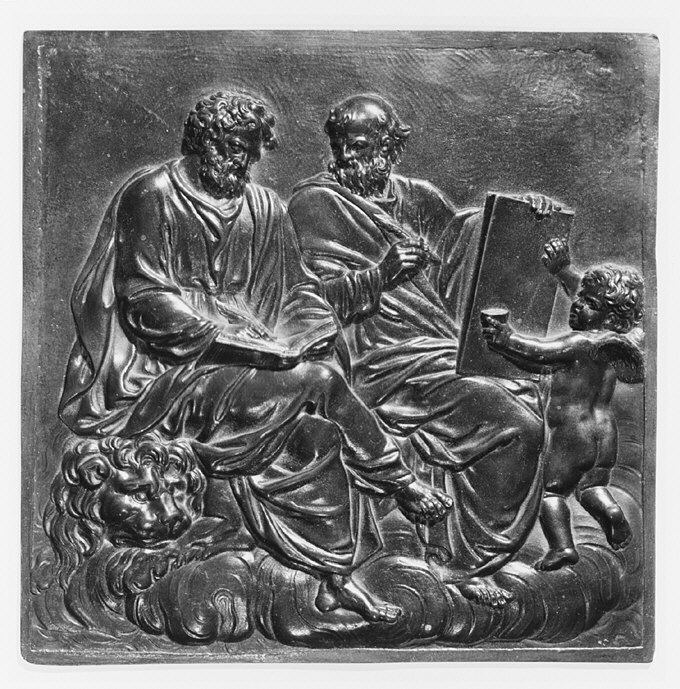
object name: relief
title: Saints Mark and Matthew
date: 1601-1700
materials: bronze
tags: reading,lions,angels,saint mark,saint matthew